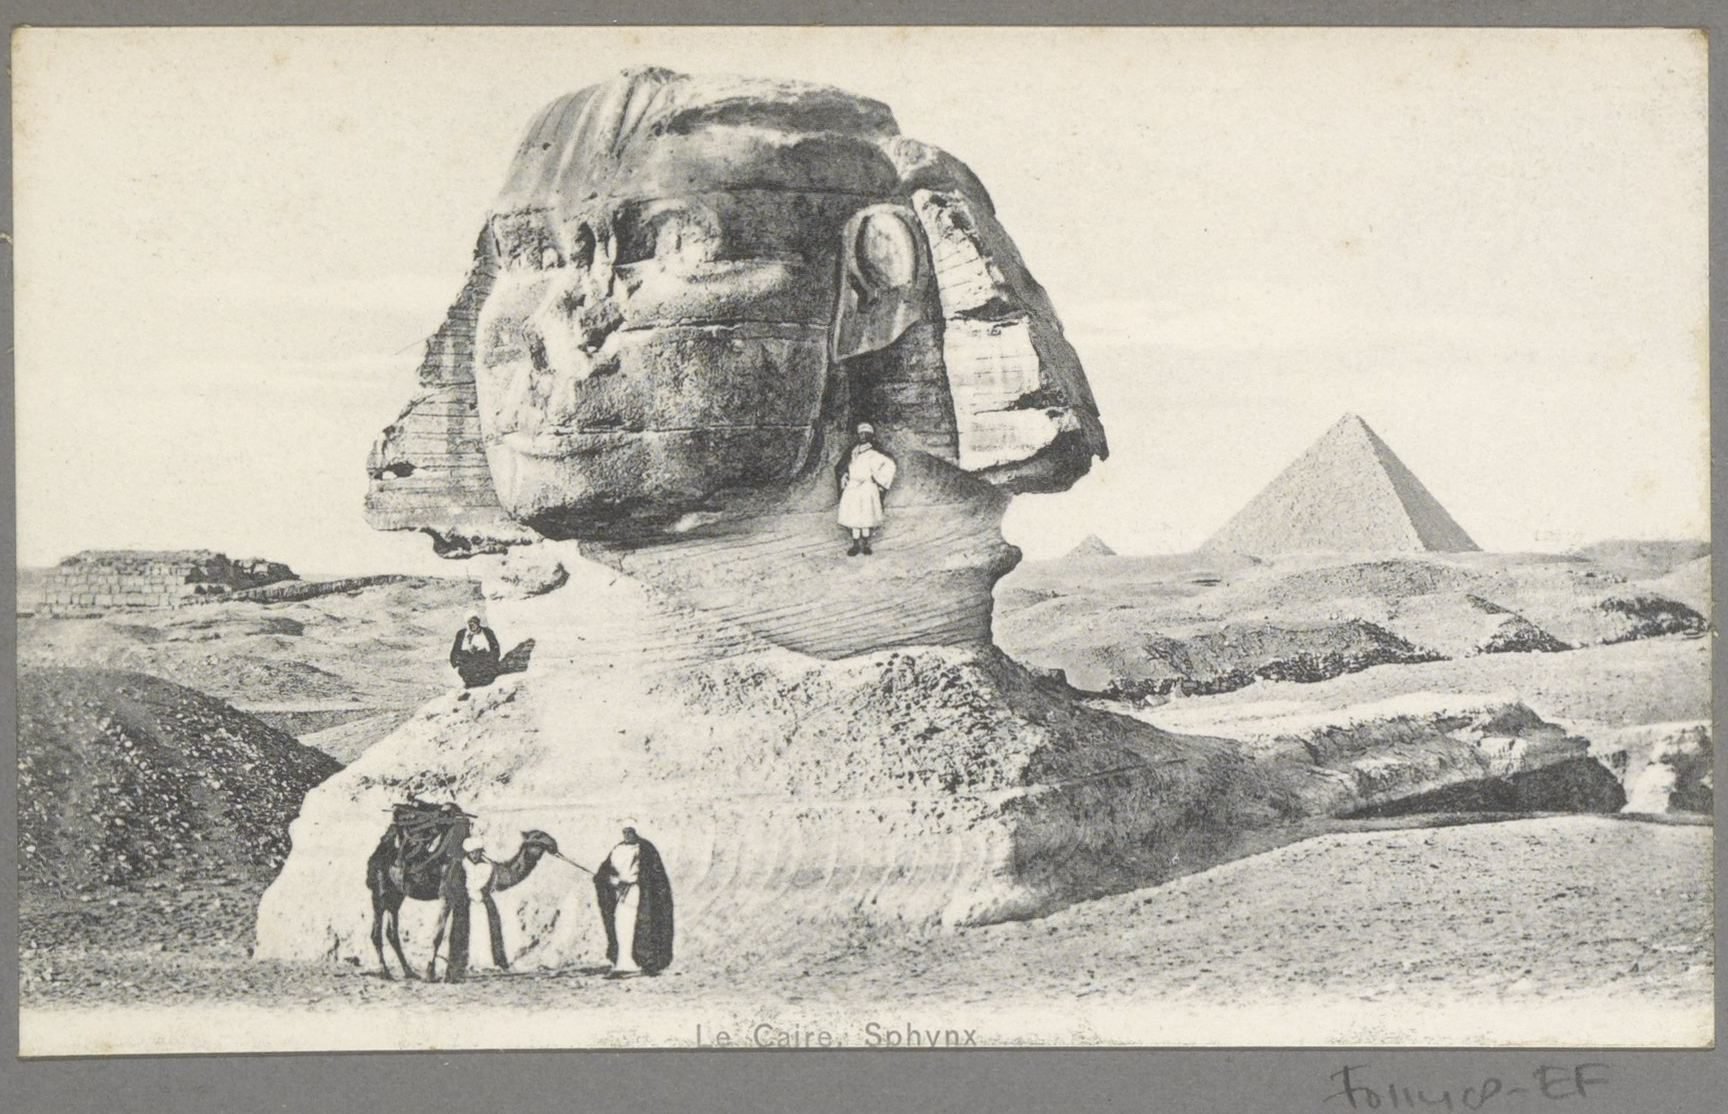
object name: ansichtkaart, prentbriefkaart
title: Le Caire Sphynx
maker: Anonymous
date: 1895-1905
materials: paper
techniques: photograph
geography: cairo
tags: sphinx (lion/woman); 'sfinge' (ripa) - aa - female human figure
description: Onderdeel van Reisalbum met foto's van bezienswaardigheden in Griekenland en Egypte.